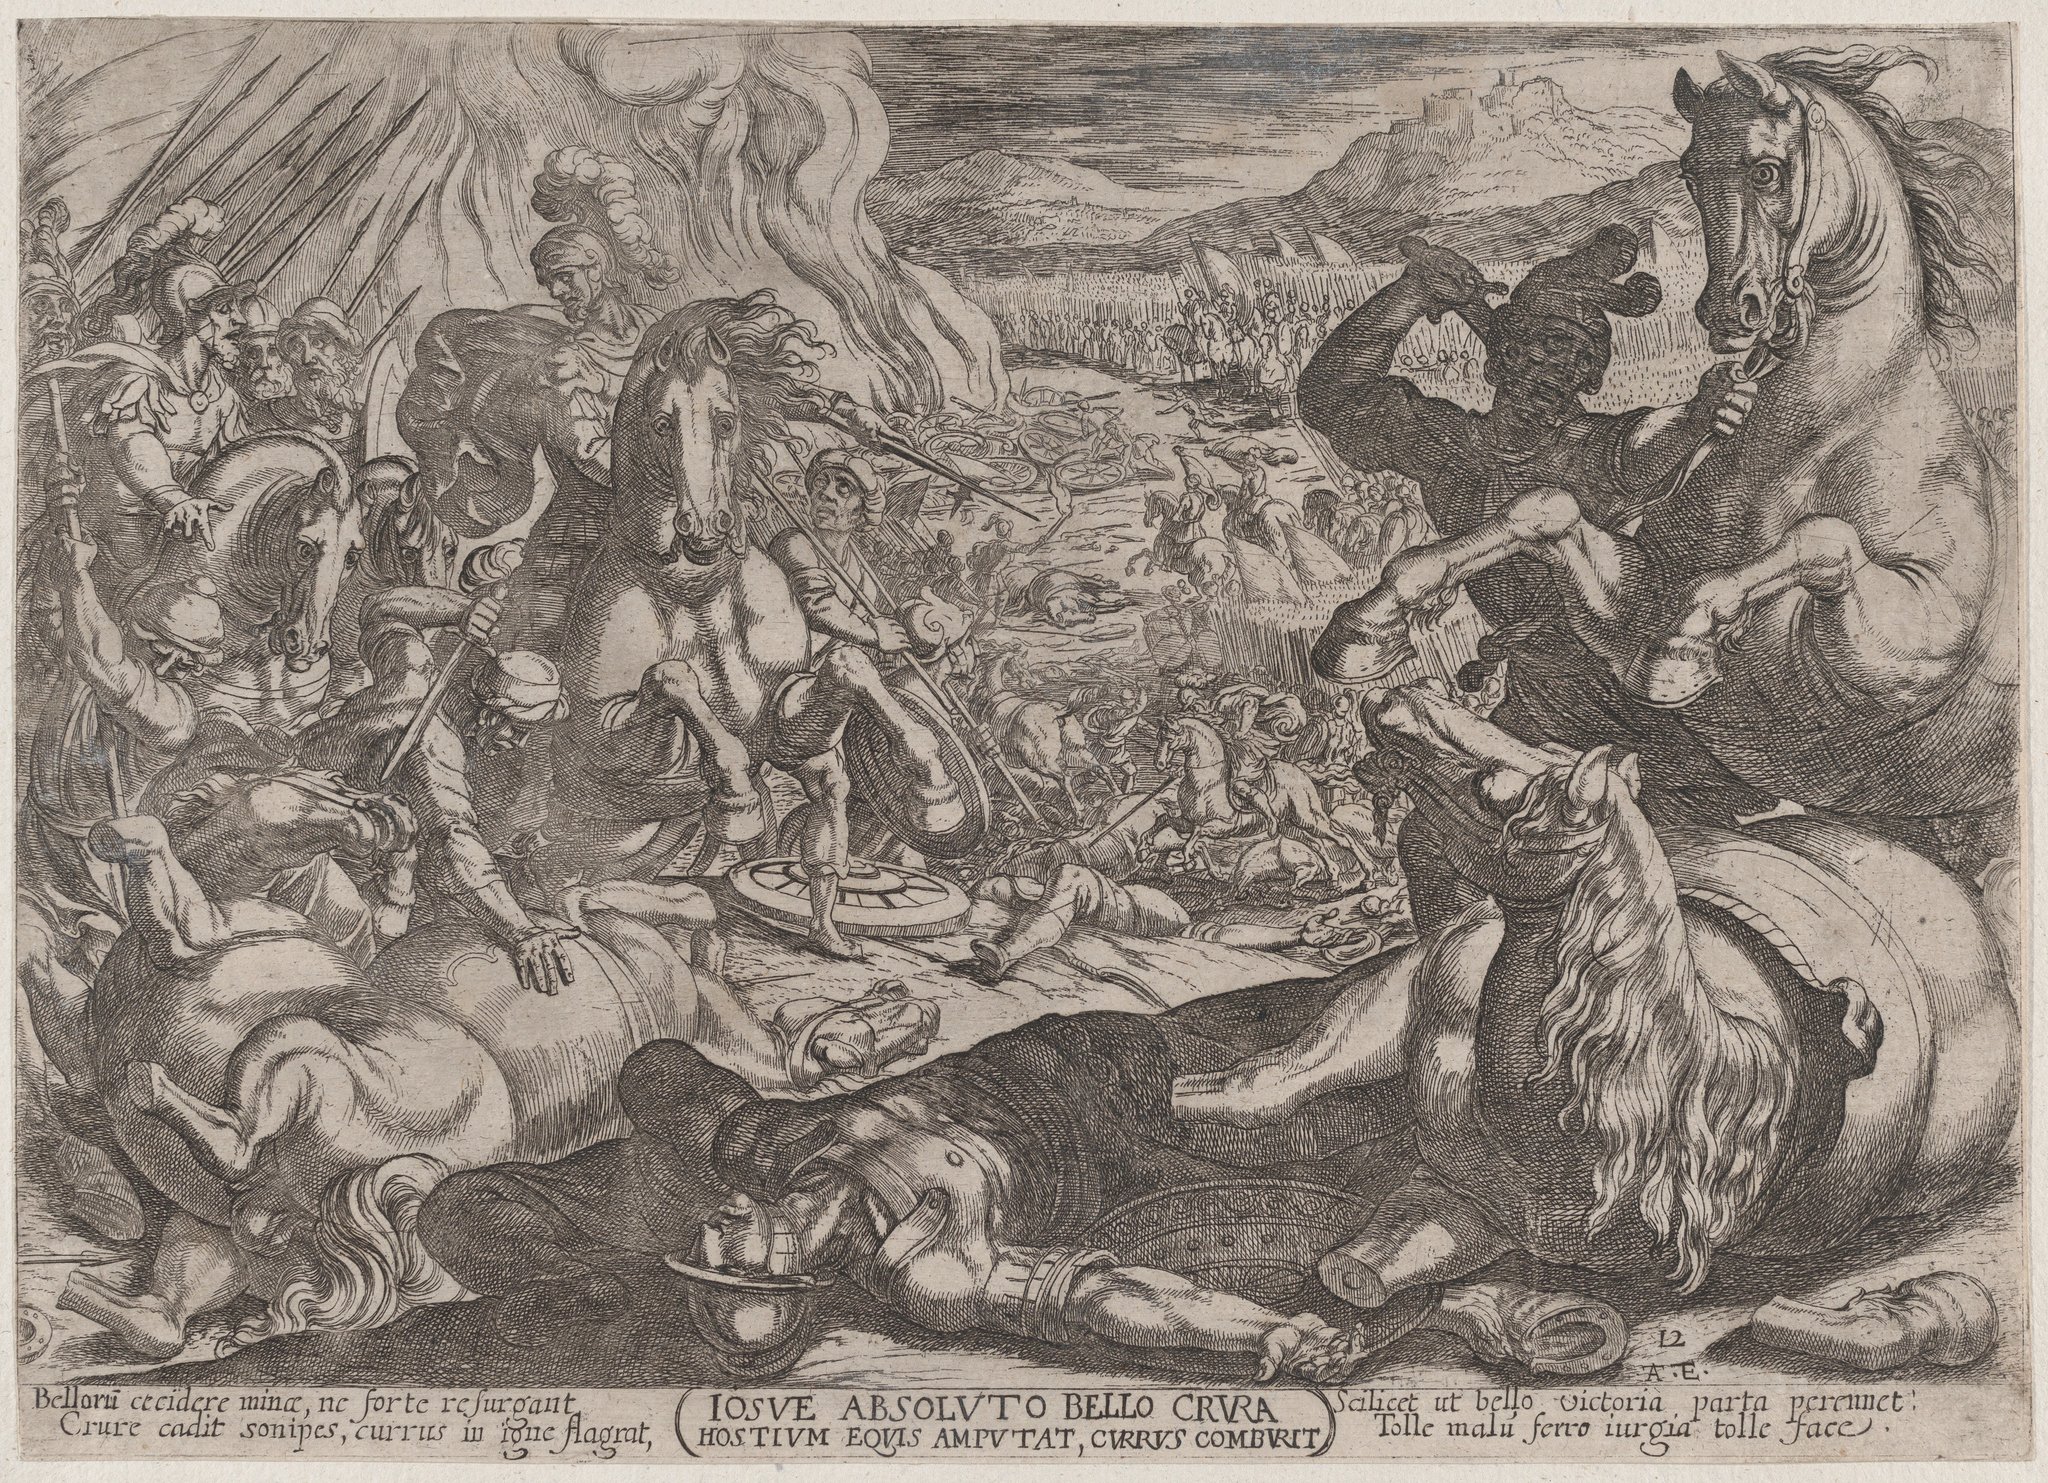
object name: print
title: Plate 12: Joshua Mutilates his Enemies' Horses, from "The Battles of the Old Testament"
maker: antonio tempesta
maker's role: artist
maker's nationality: italian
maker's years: 1555-1630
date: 1590-1610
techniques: etching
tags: battles,soldiers,horses,death